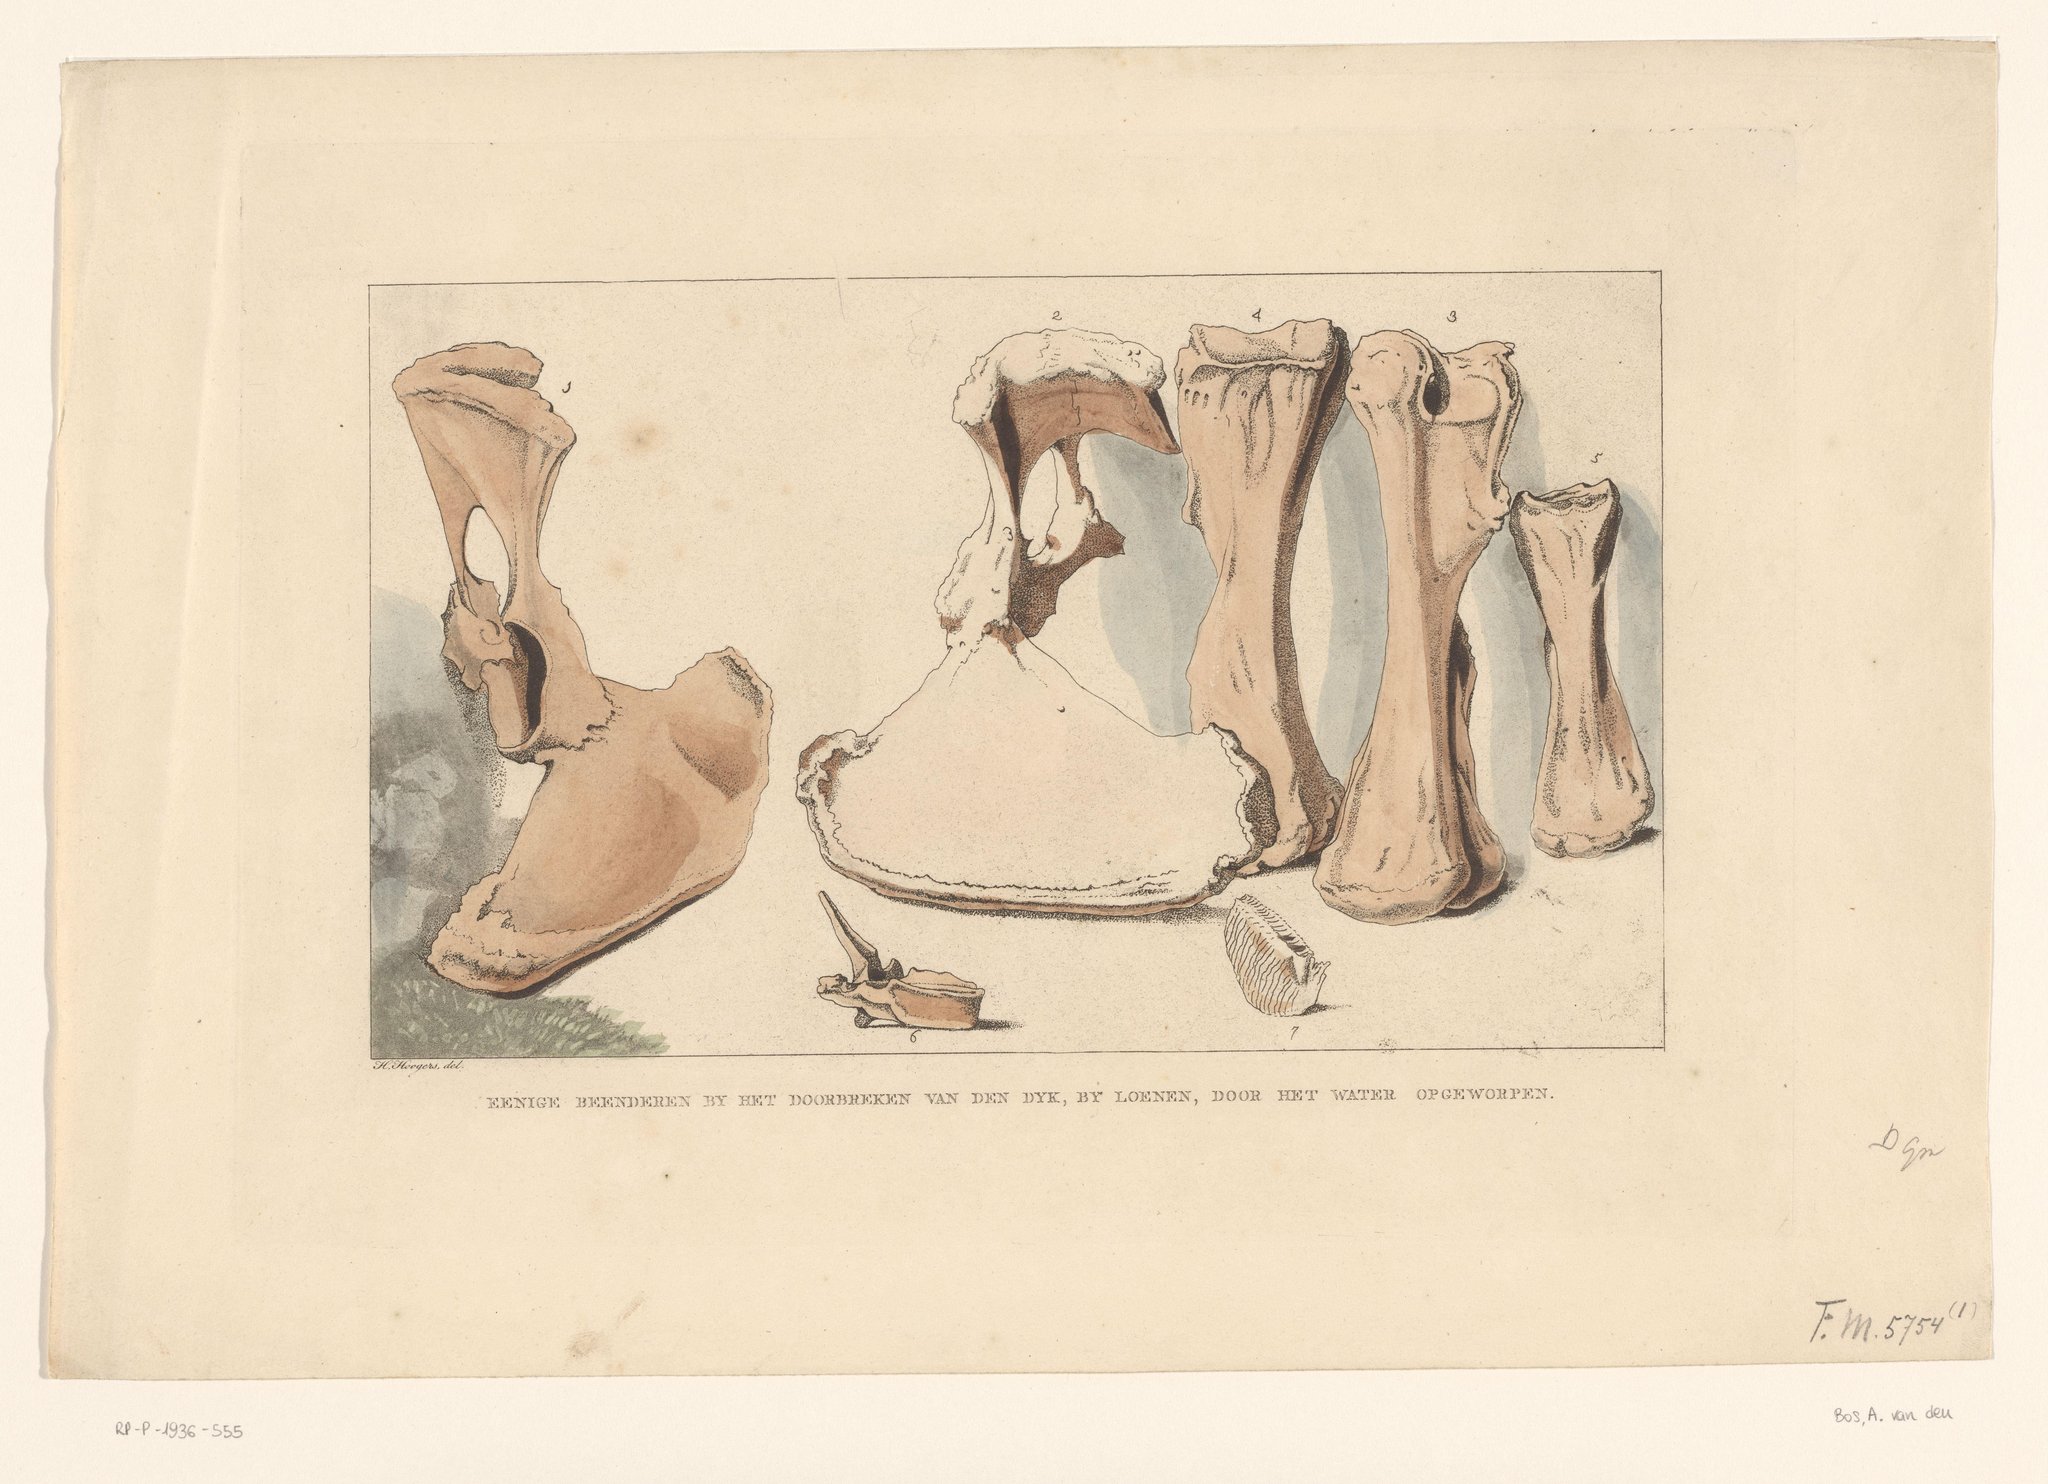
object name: print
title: Fossiele beenderen gevonden tijdens de watersnood bij Loenen, 1809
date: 1809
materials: paper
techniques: aquatint, etching, hand coloring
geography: netherlands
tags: fossil animals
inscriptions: collector's mark: Lugt 2228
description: Prent waarschijnlijk uit een deel van: Ewijk, Hendrik. Geschiedkundig verslag der dijkbreuken en overstroomingen, langs de rivieren in het Koningrijk Holland, voorgevallen in louwmaand MDCCCIX. 3 dln. Amsterdam: Johannes Allart en Jacobus Ruys, 1809.